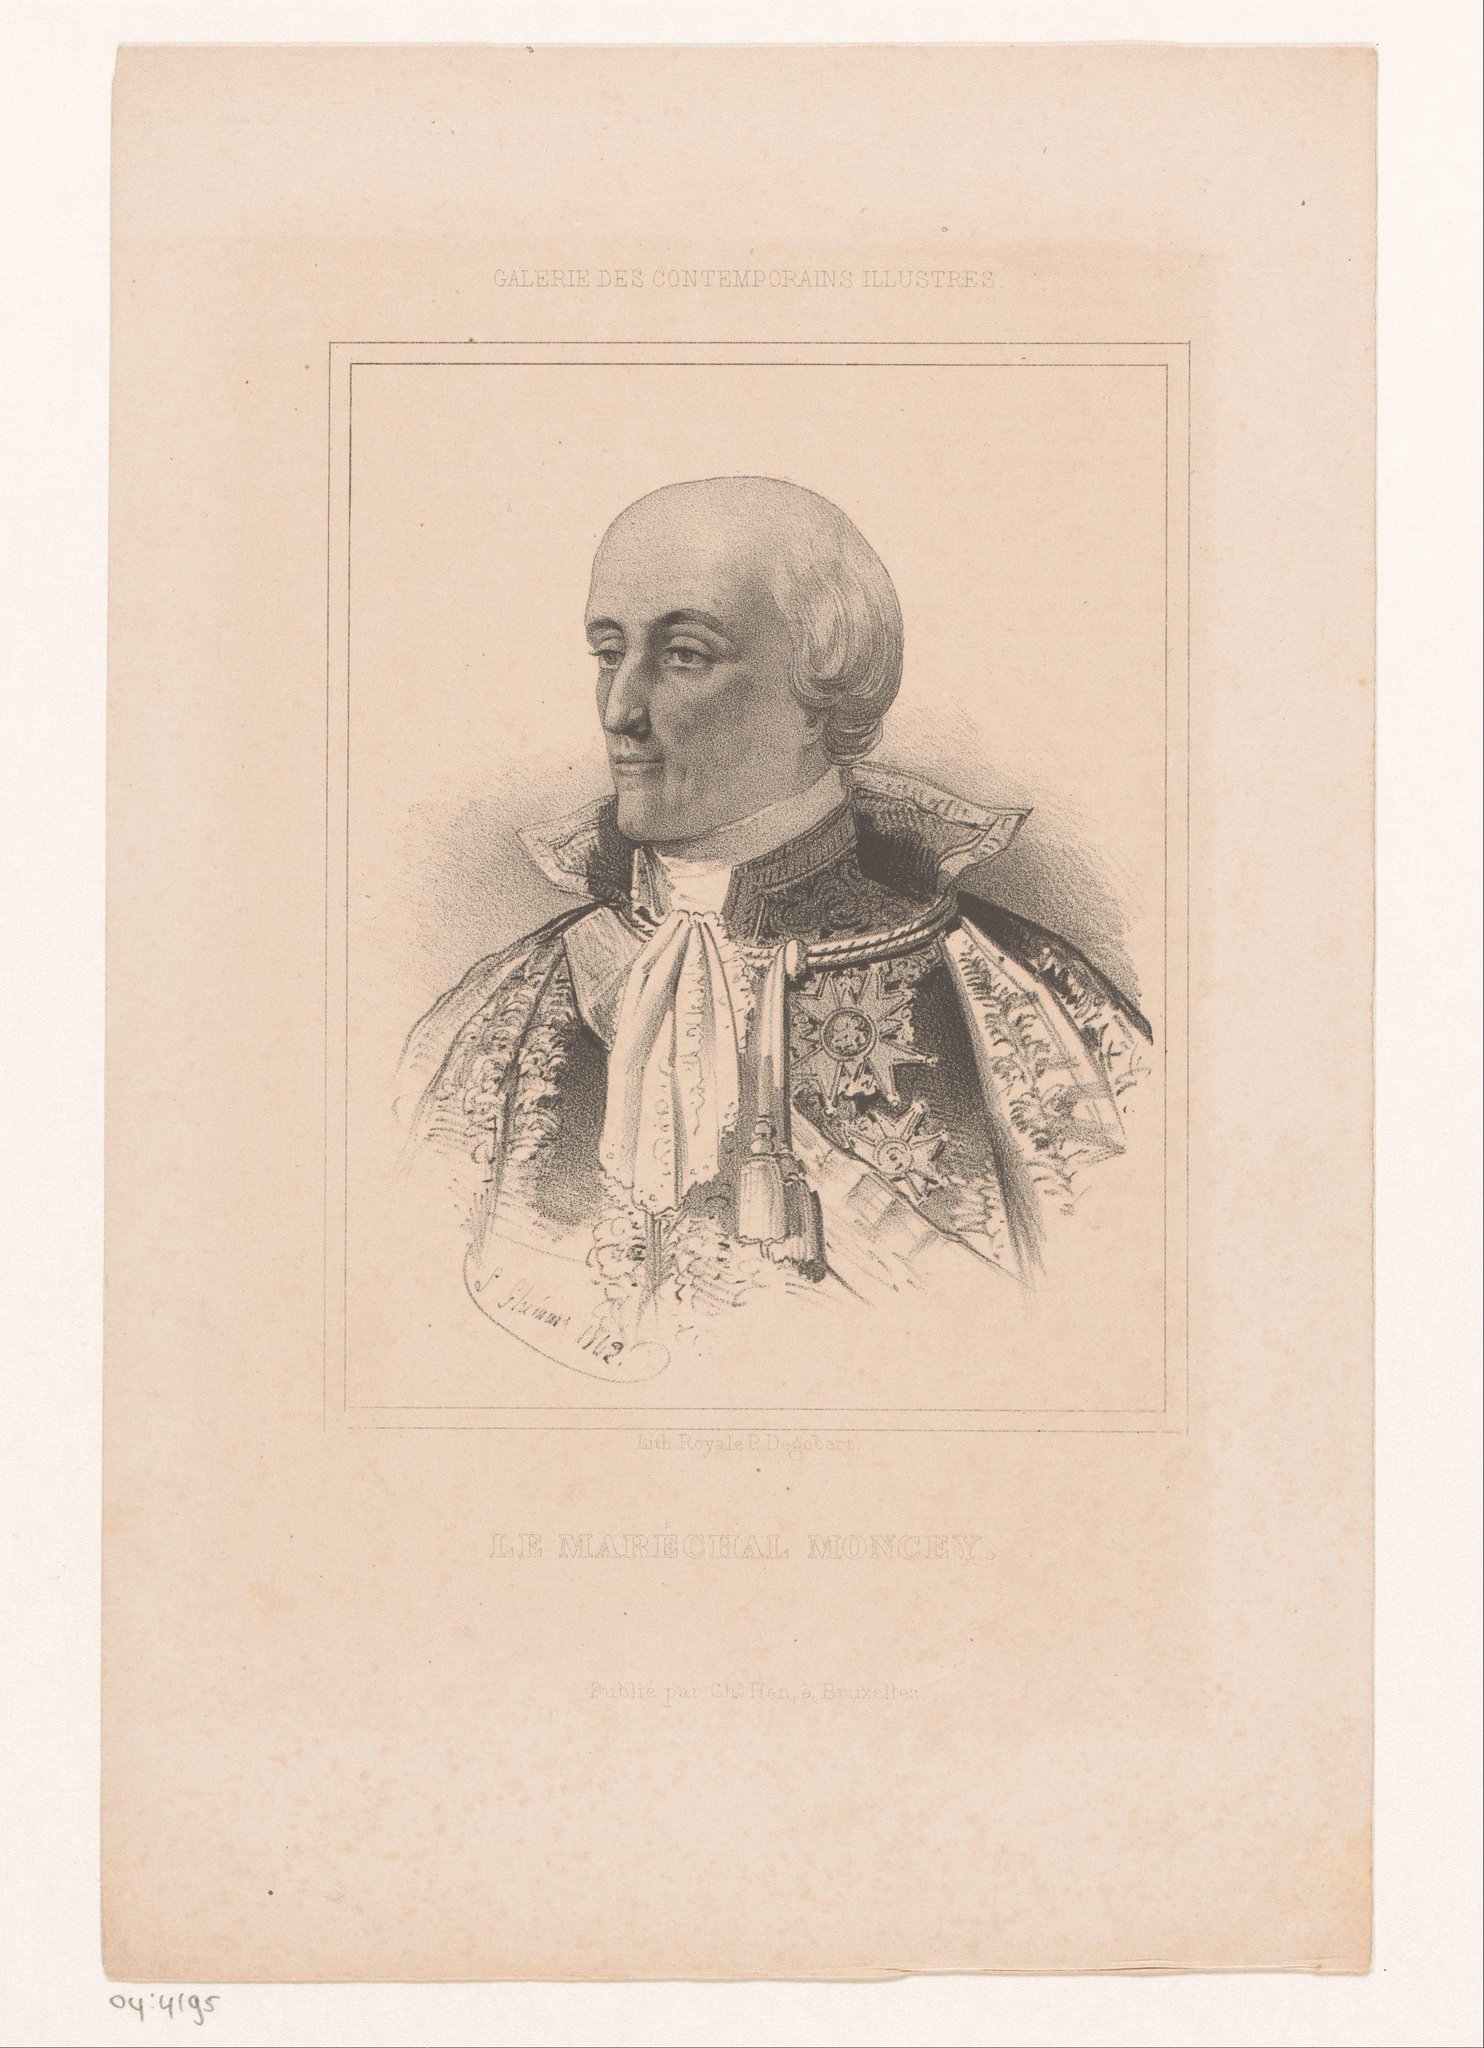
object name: print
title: Galerie des contemporains illustres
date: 1842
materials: paper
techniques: lithograph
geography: brussels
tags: paris, adult man, historical persons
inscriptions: collector's mark: Lugt 2228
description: Prent waarschijnlijk verschenen in een uitgave van: Galerie des contemporains illustres, par un homme de rien; of in een uitgave van: Galerie des contemporains illustres. Brussel: Ch. Hen, 1841.